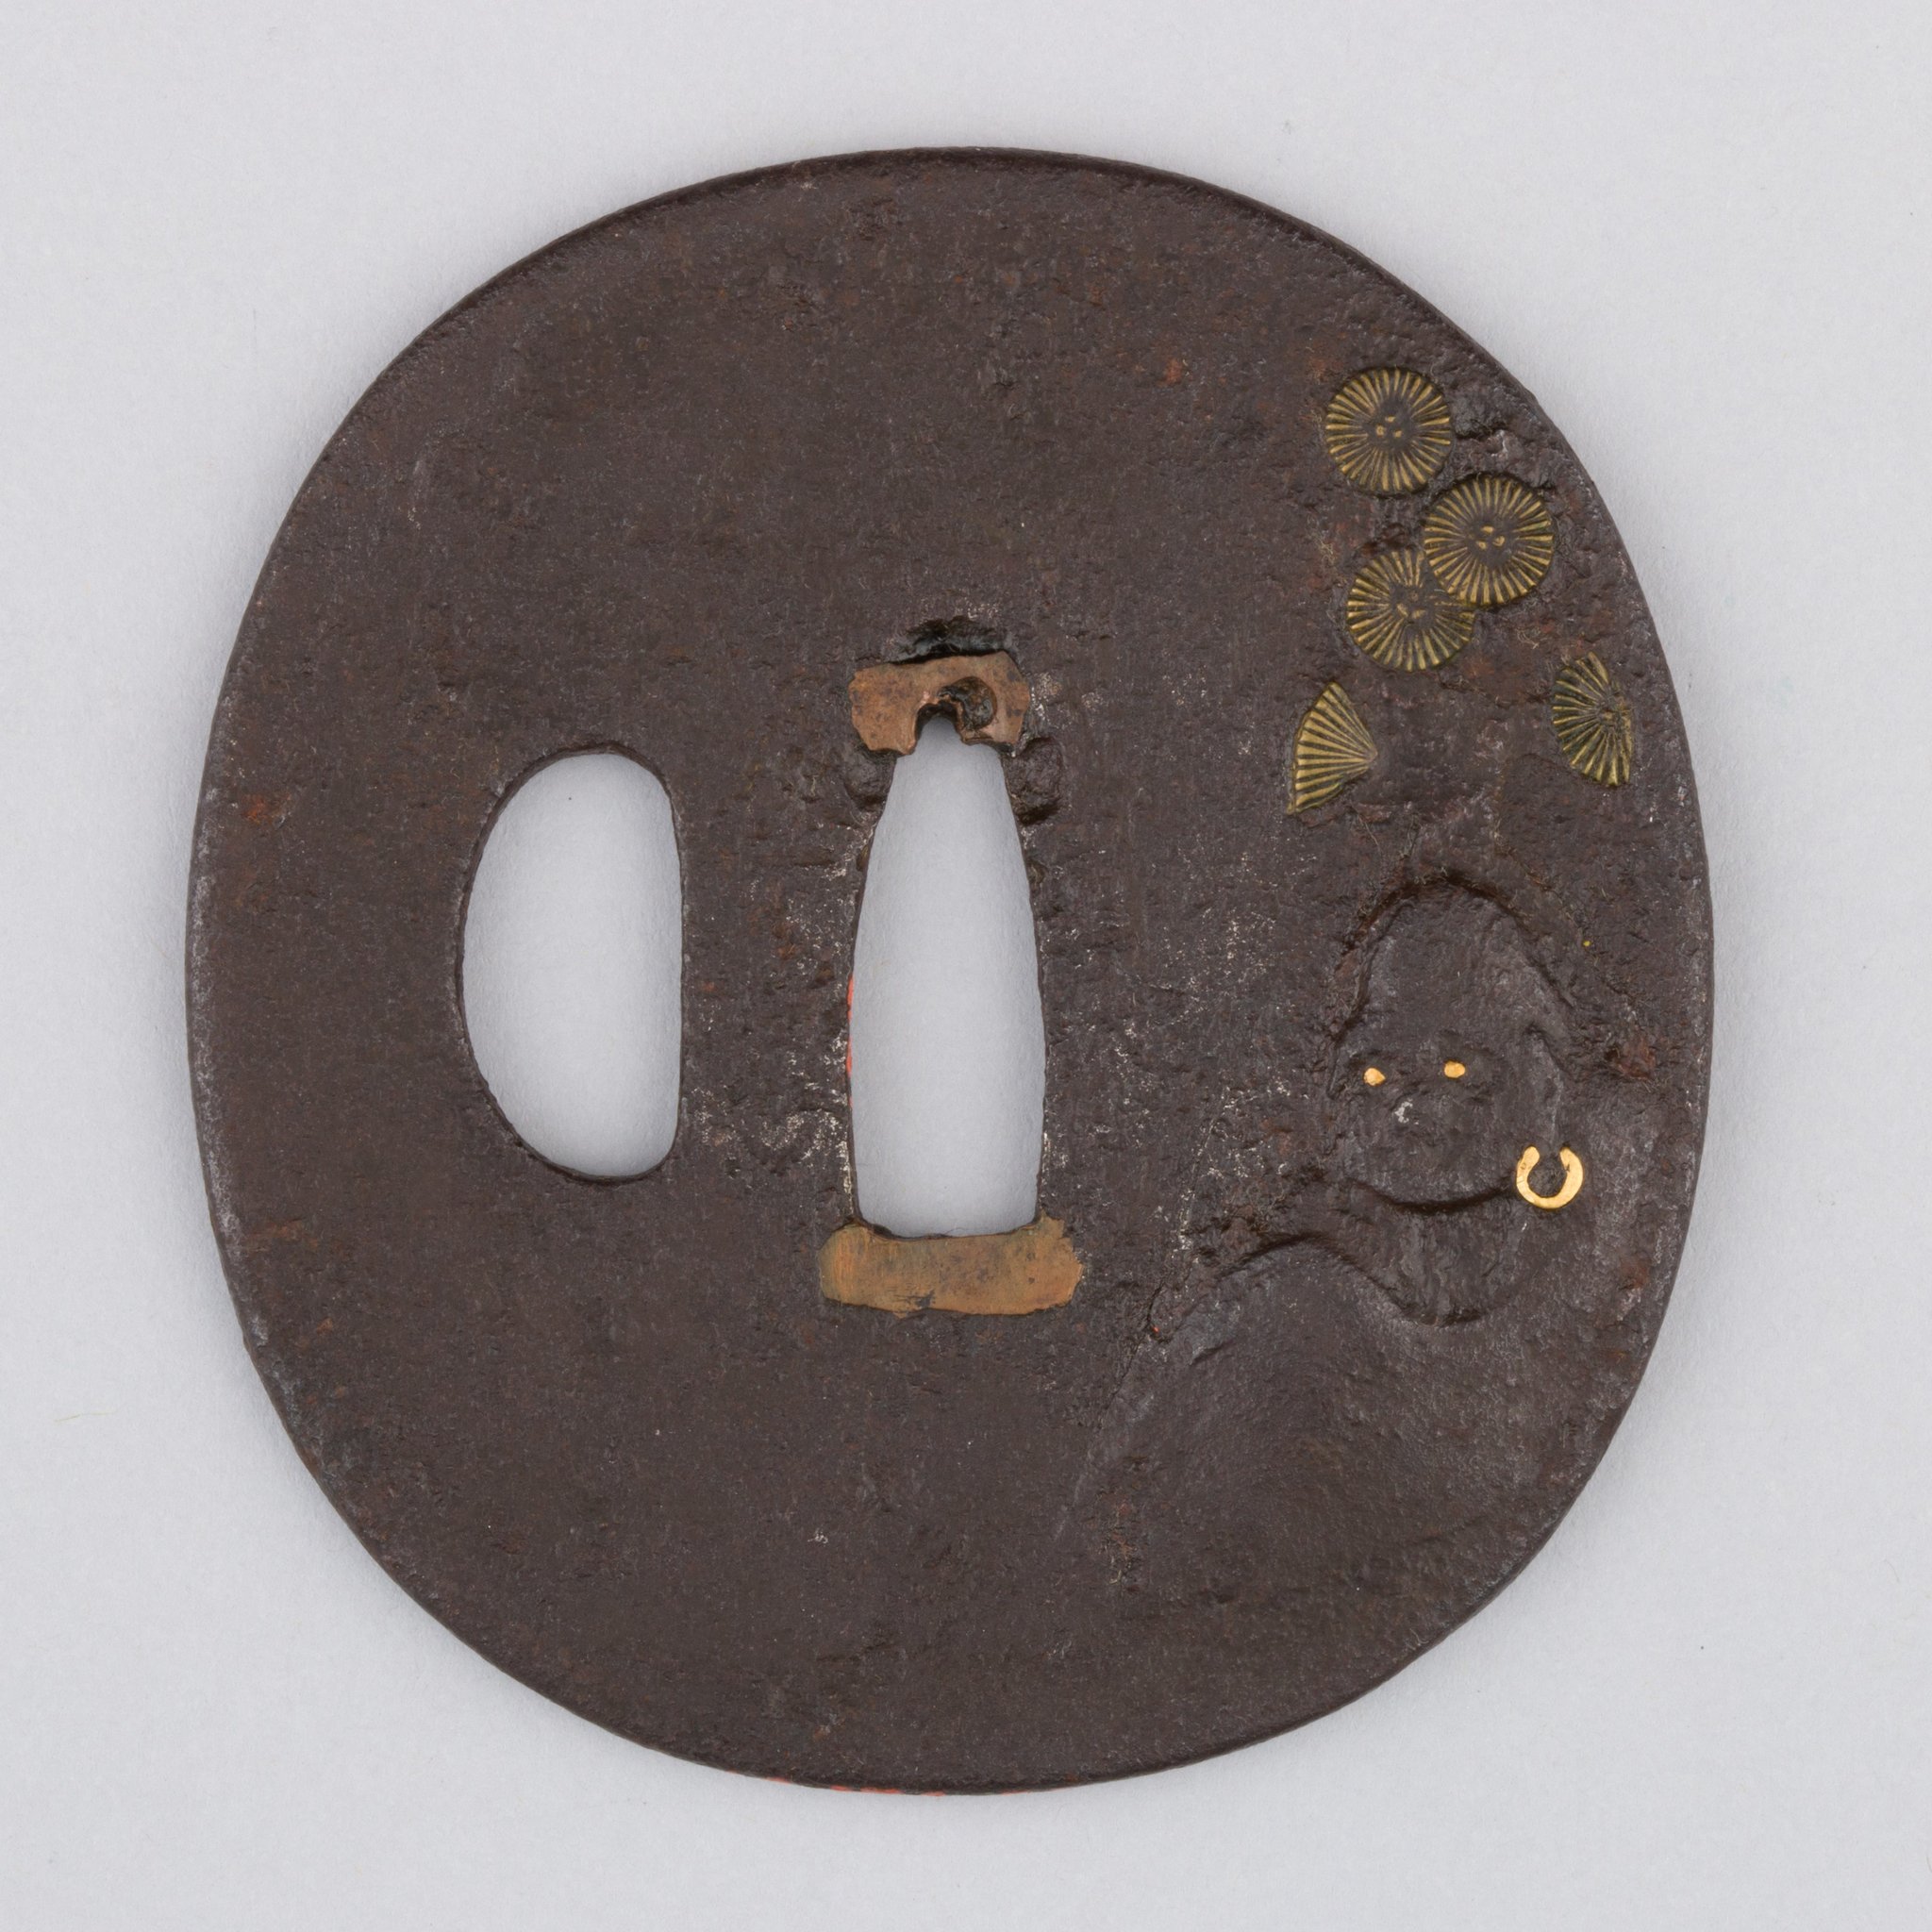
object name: sword guard tsuba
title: Sword Guard (Tsuba)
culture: japanese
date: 1615-1868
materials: copper, iron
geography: japan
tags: men